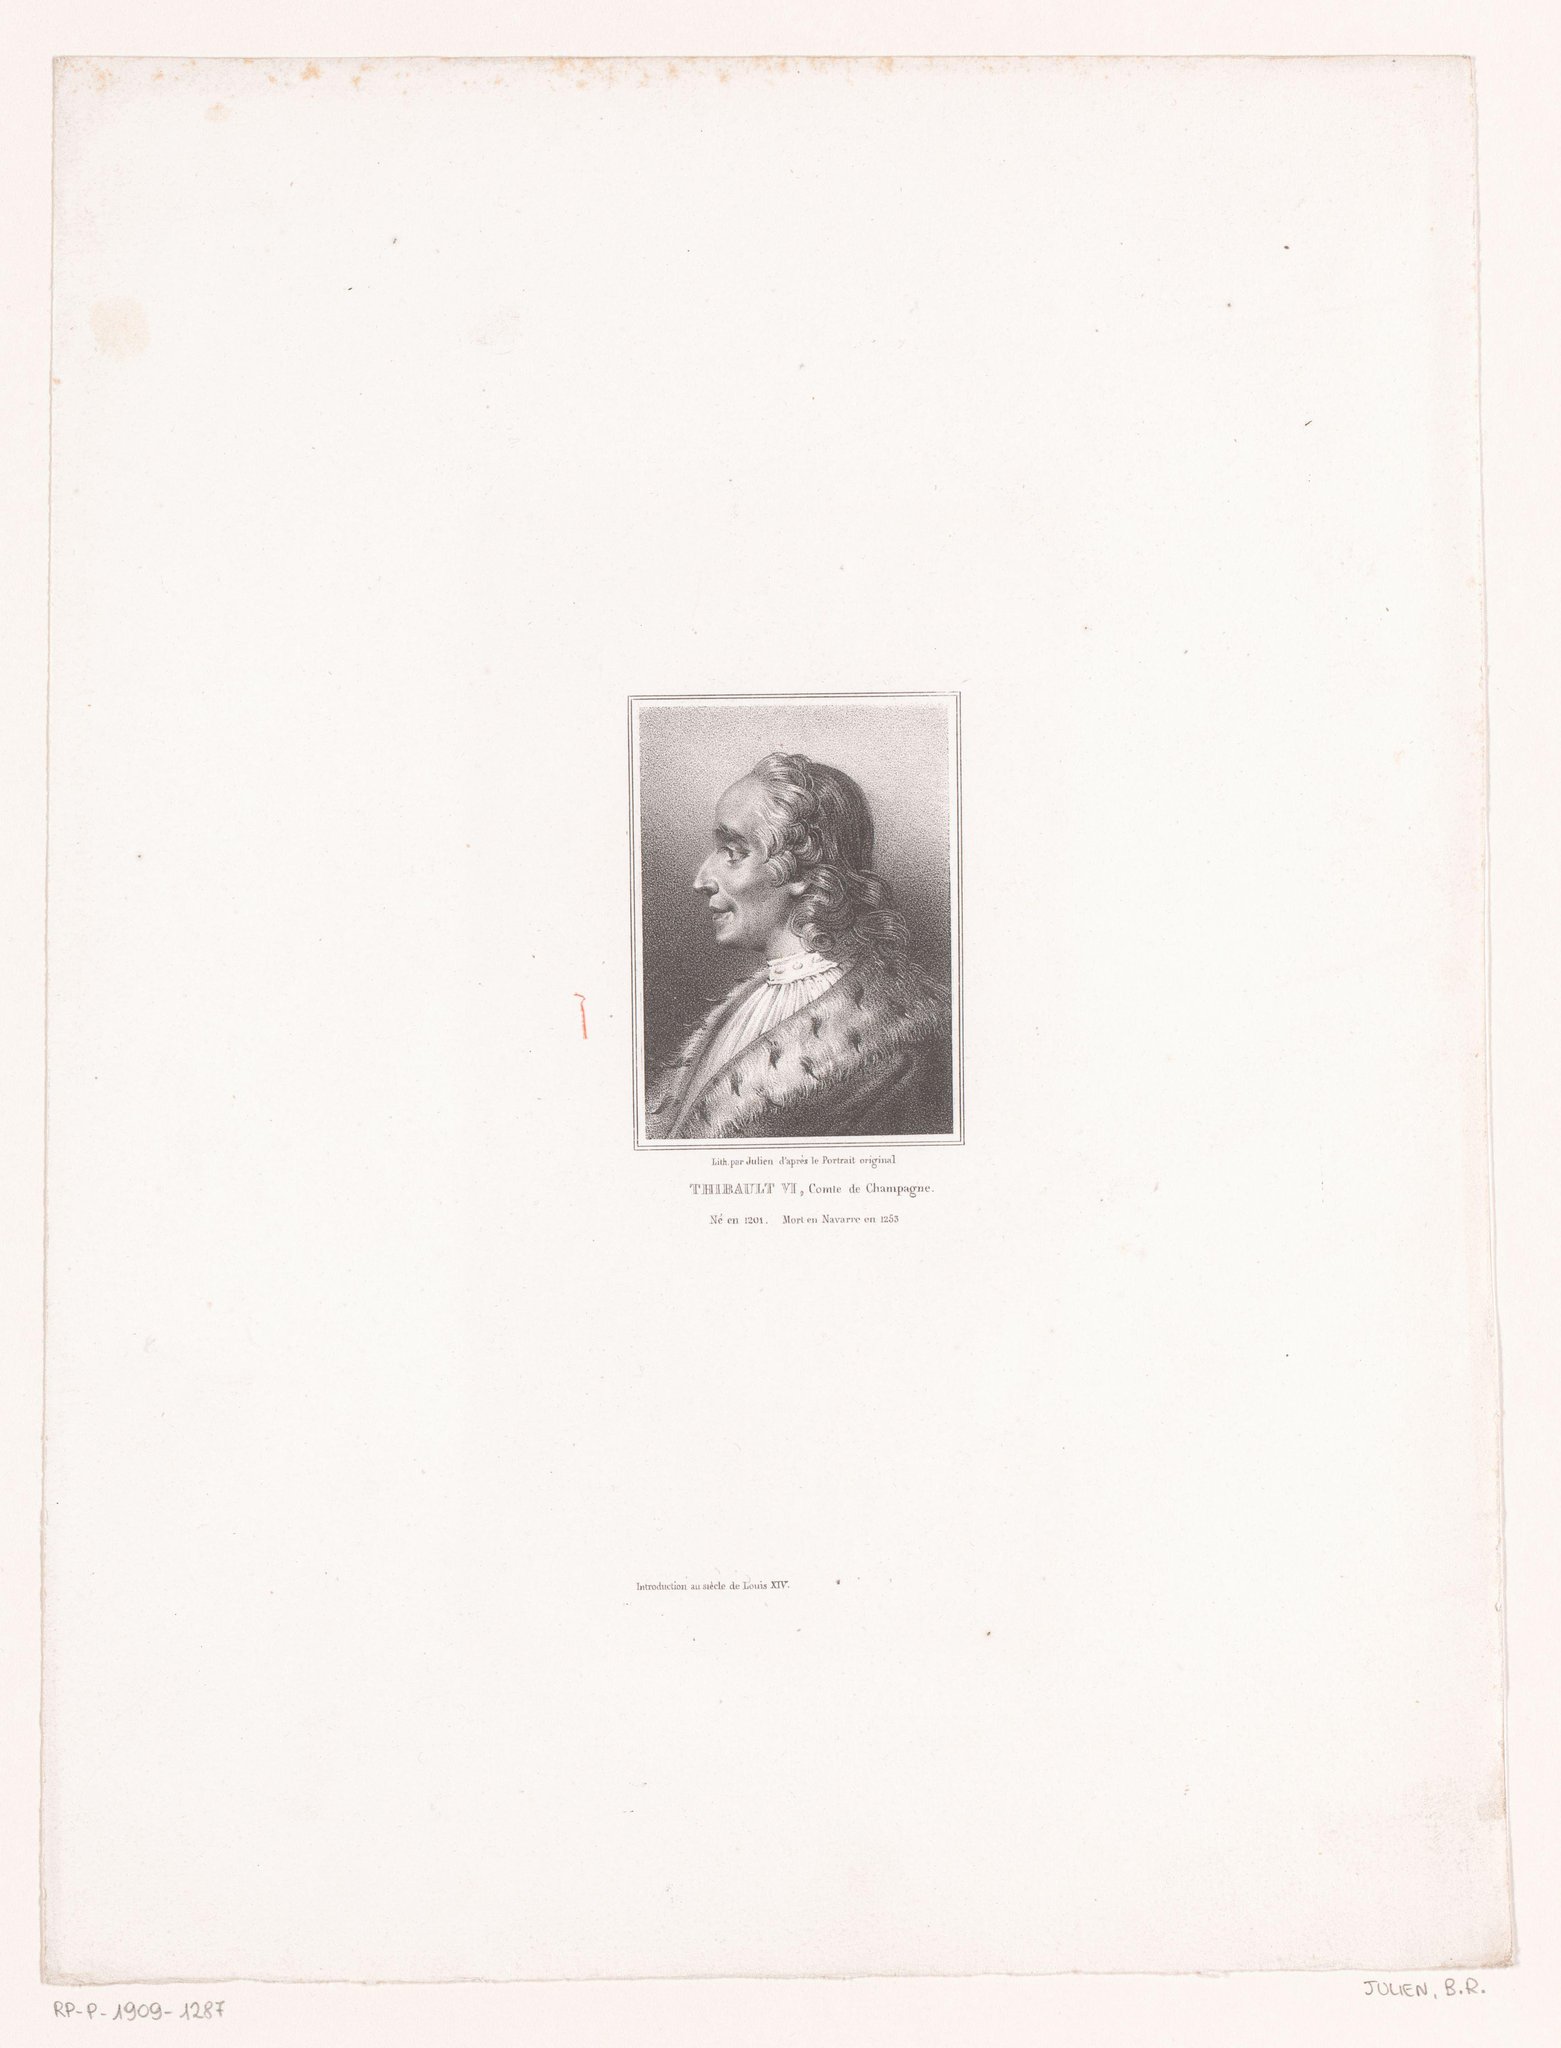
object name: print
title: Thibault VI, Comte de Champagne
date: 1830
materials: paper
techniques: lithograph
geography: paris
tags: earl, historical persons, portrait of a writer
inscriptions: collector's mark: Lugt 2228a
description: Prent gebruikt voor: Illustrations du Cours de Littérature de la Harpe, ou collection de 400 portraits destinés à l'ornement de cet ouvrage. Parijs: Boblet, 1830.